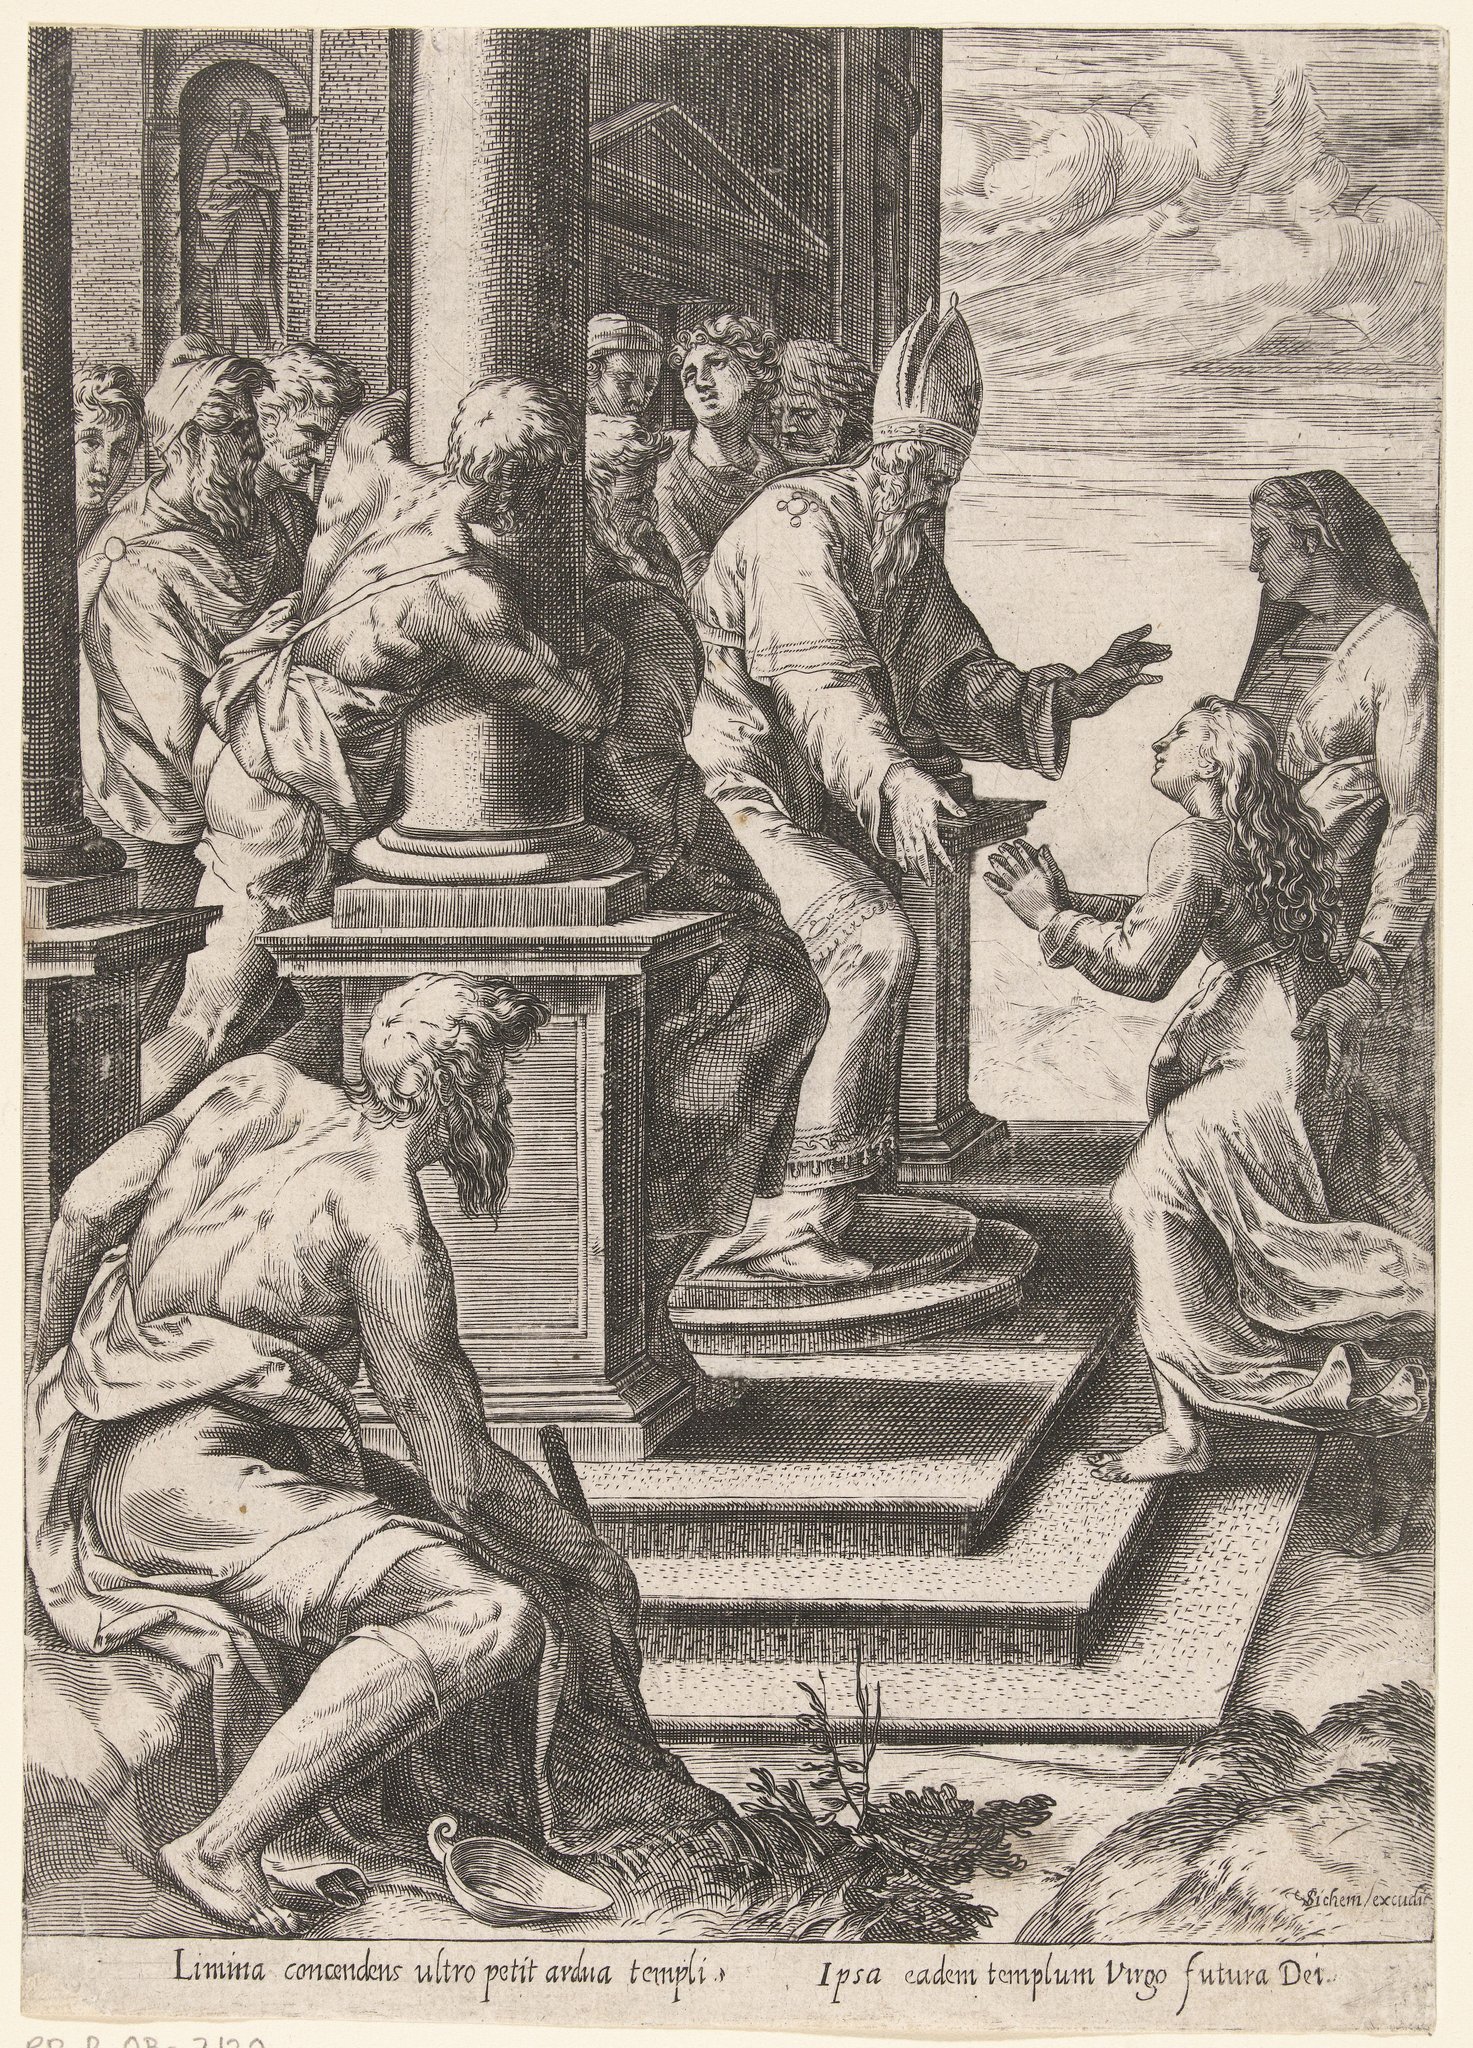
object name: print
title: Presentatie van Maria in de tempel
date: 1570-1620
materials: paper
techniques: engraving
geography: rome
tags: dedication (or presentation) of mary in the temple: she ascends the steps and is received by the high priest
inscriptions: collector's mark: Lugt 2228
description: Maria wordt door haar moeder Anna begeleidt naar de tempel. Voor de deur van de tempel wordt zij opgewacht door de hogepriester Zacharias.